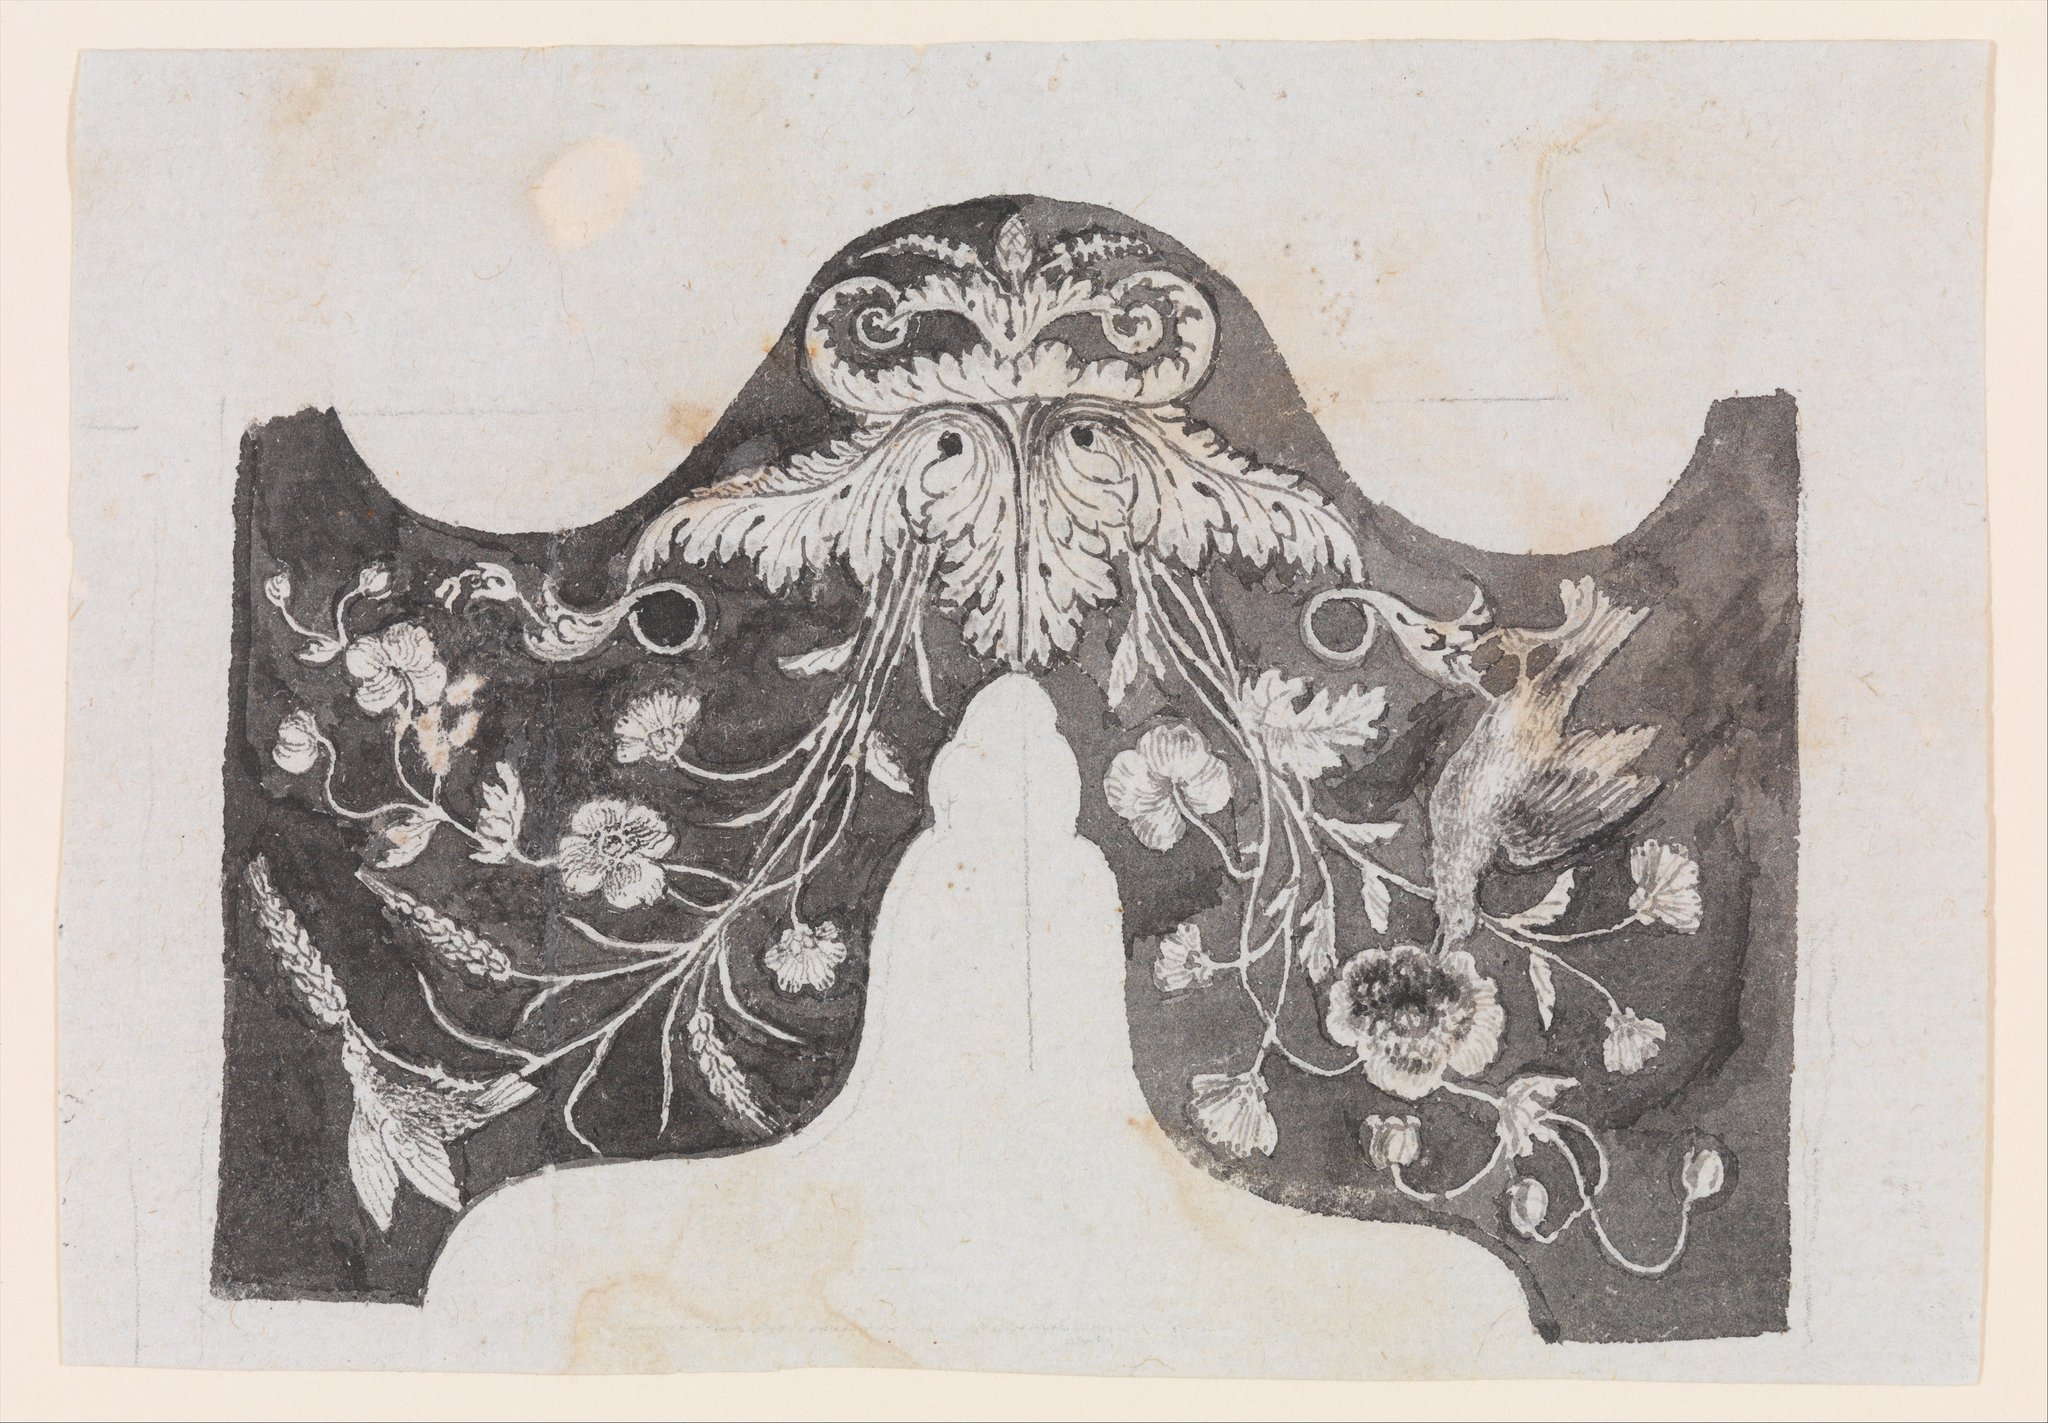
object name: drawing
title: Design for the Decoration of the Surround of the Ramrod Pipe of a Firearm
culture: french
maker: nicolas noël boutet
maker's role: designer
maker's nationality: french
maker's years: 1761-1833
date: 1795-1805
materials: ink, paper, pencil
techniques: wash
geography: france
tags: birds